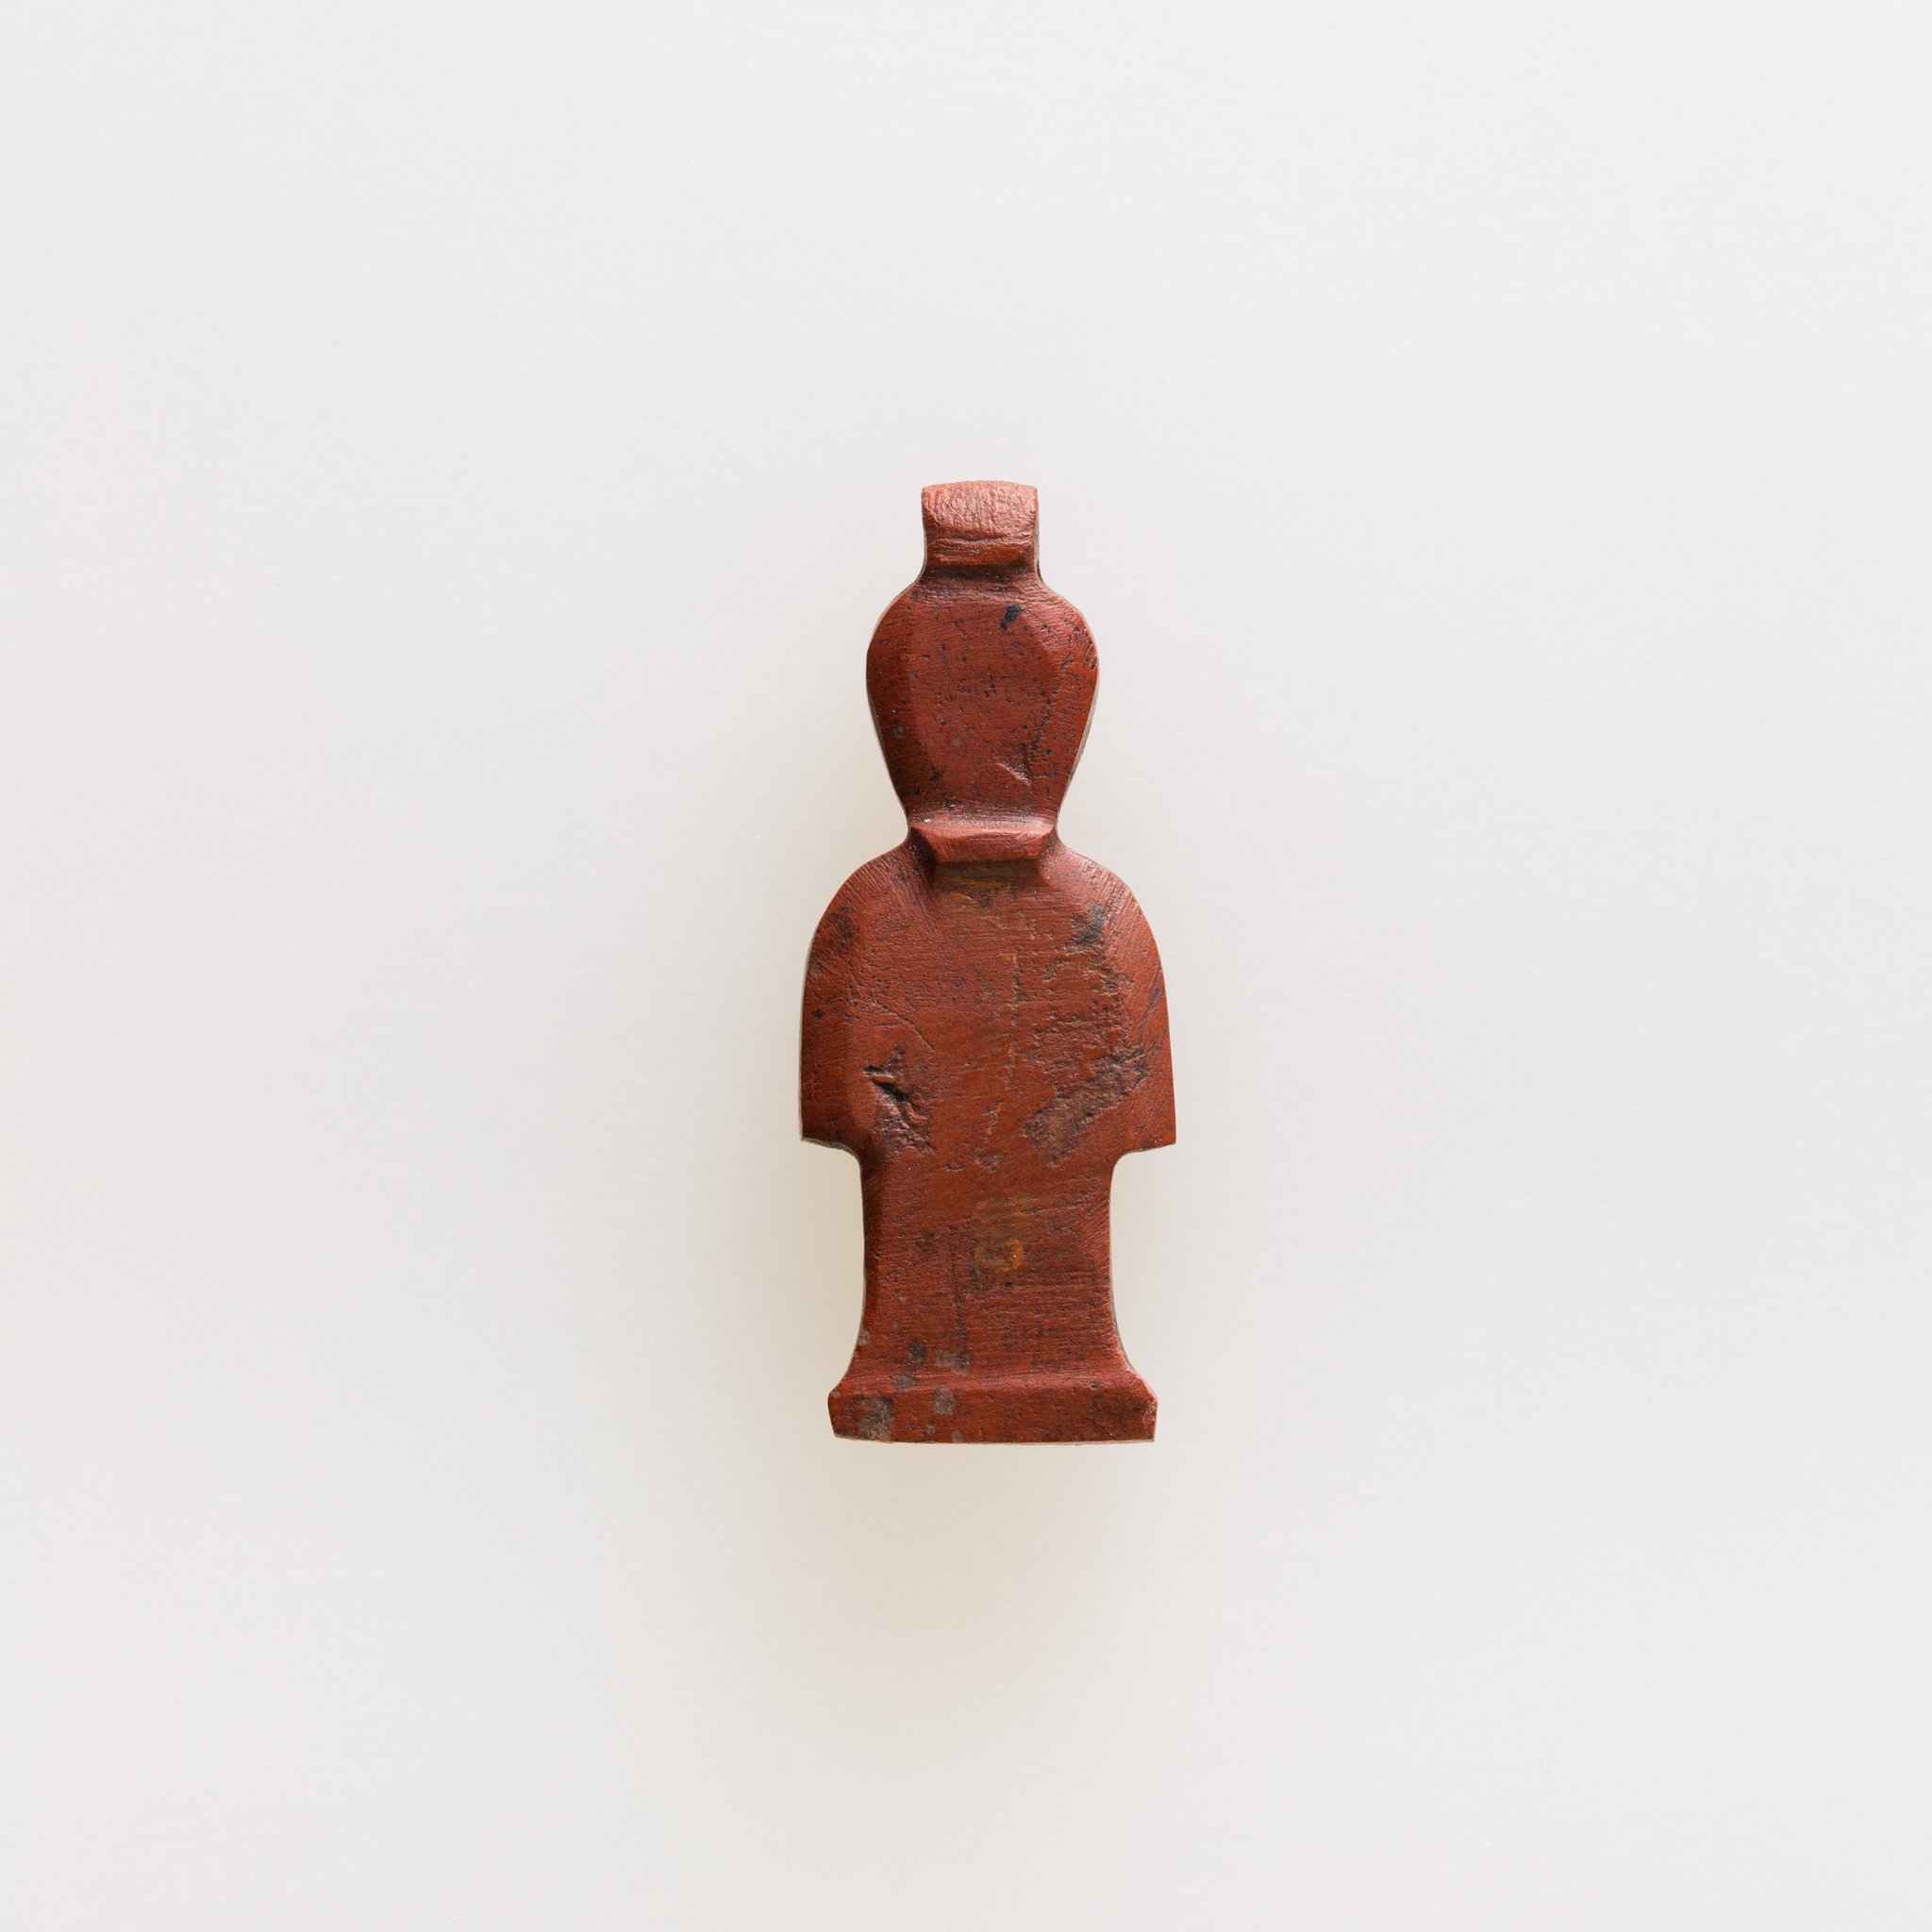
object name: amulet, tit, isi knot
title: Tit (Isis knot) amulet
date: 525-30 BCE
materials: glass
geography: egypt